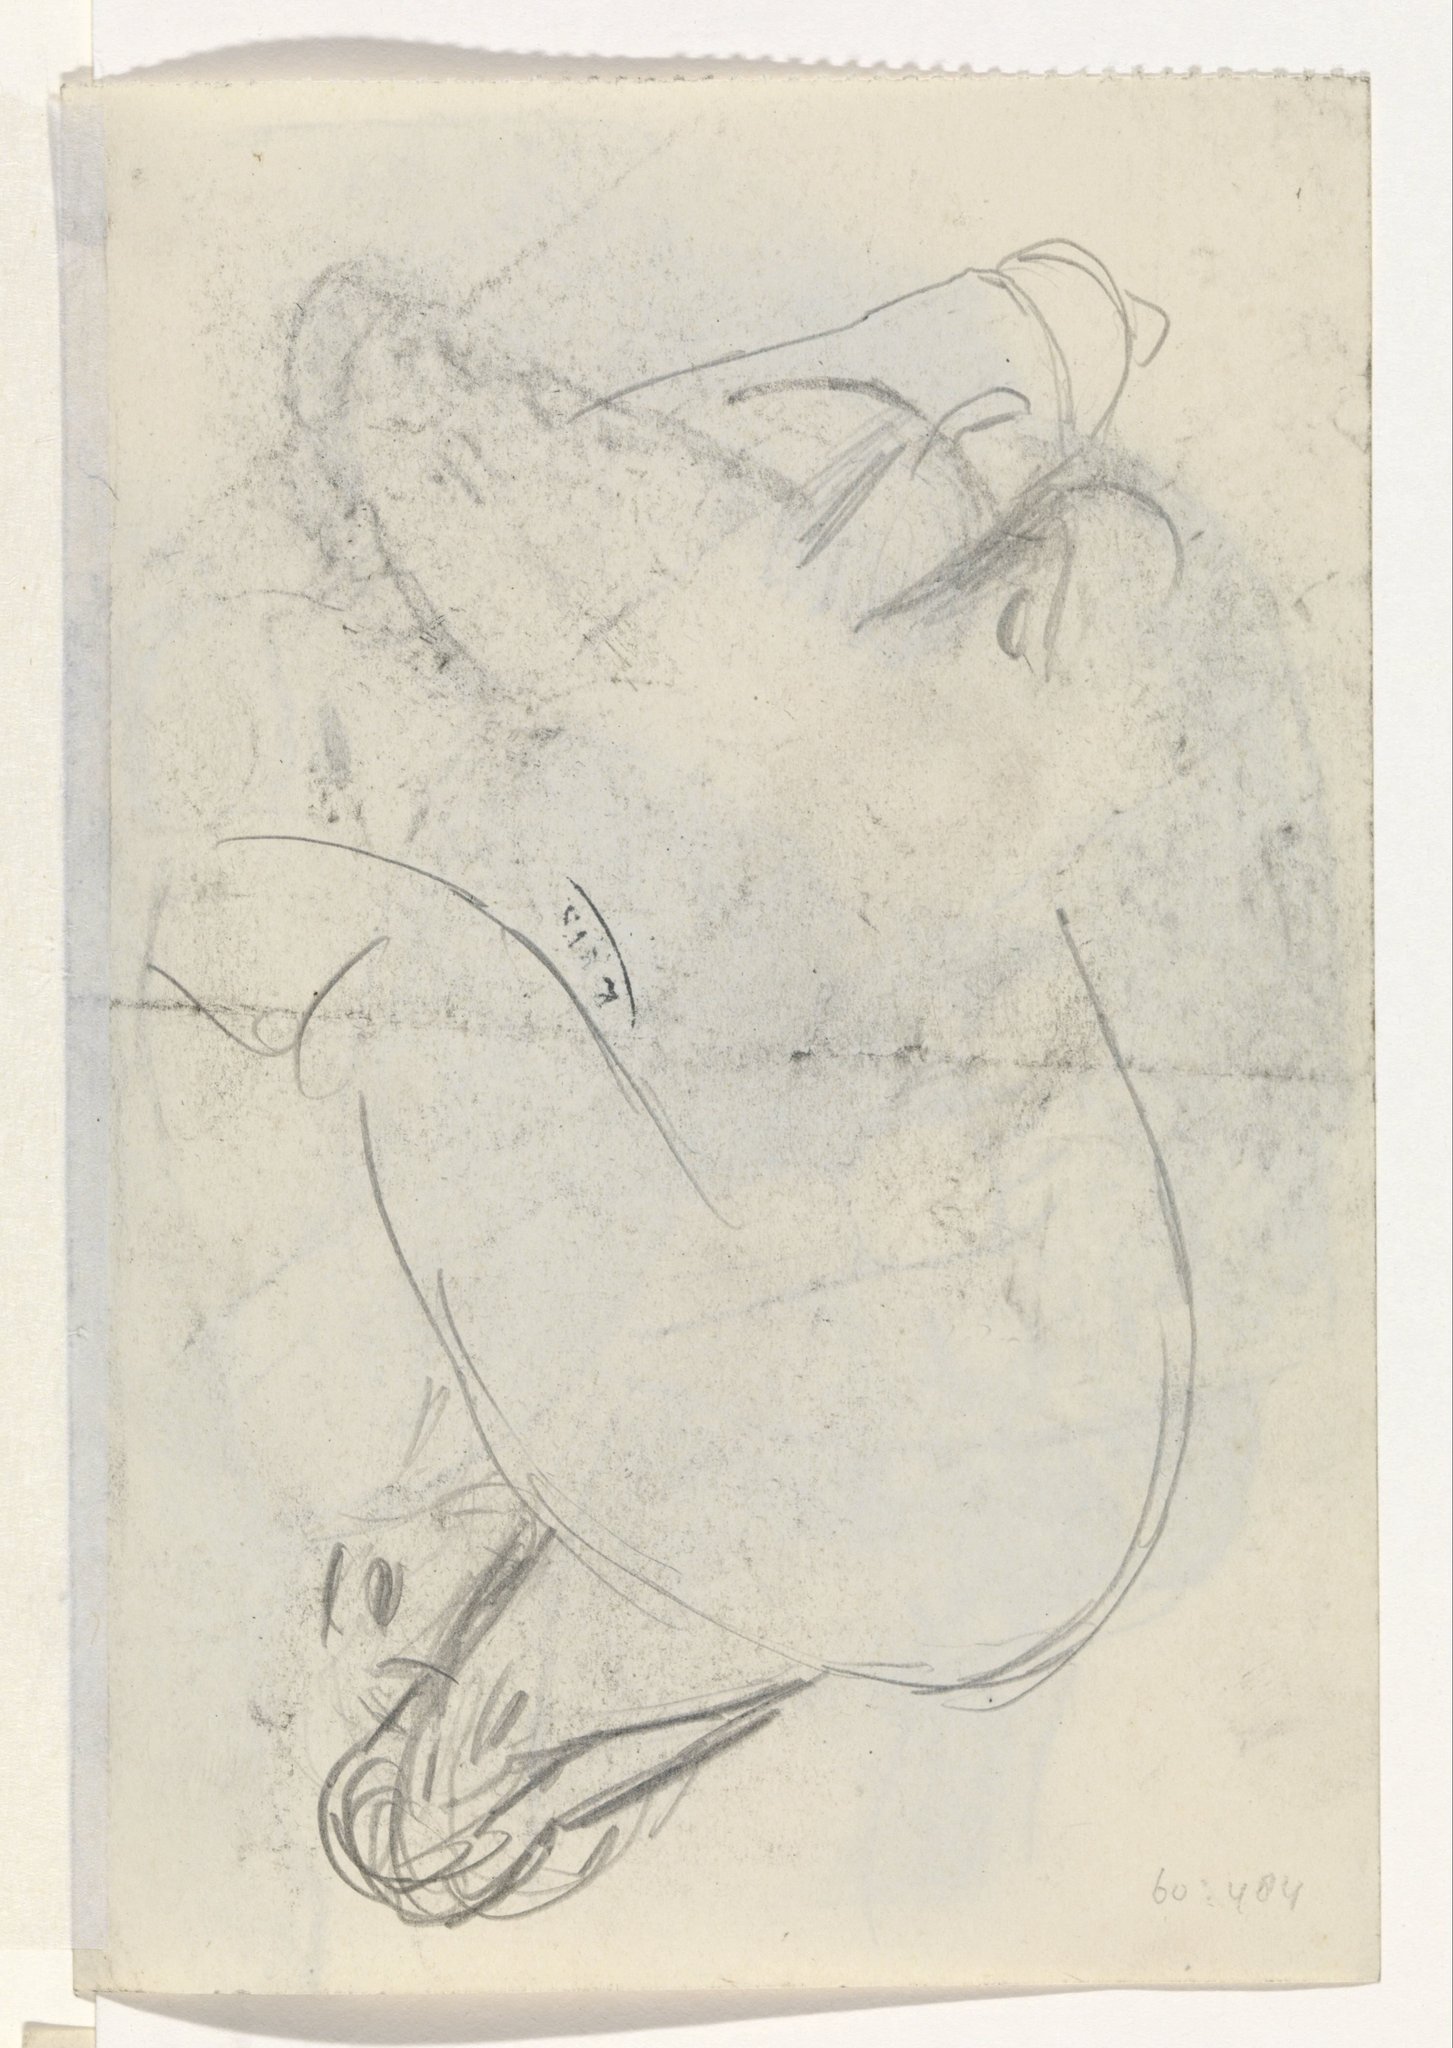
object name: drawing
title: Twee kussende stellen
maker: leo gestel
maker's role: draughtsman, print maker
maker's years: 1881-1941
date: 1891-1941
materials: paper, pencil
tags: (lovers) kissing each other, embracing each other, kissing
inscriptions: collector's mark: Lugt 2228